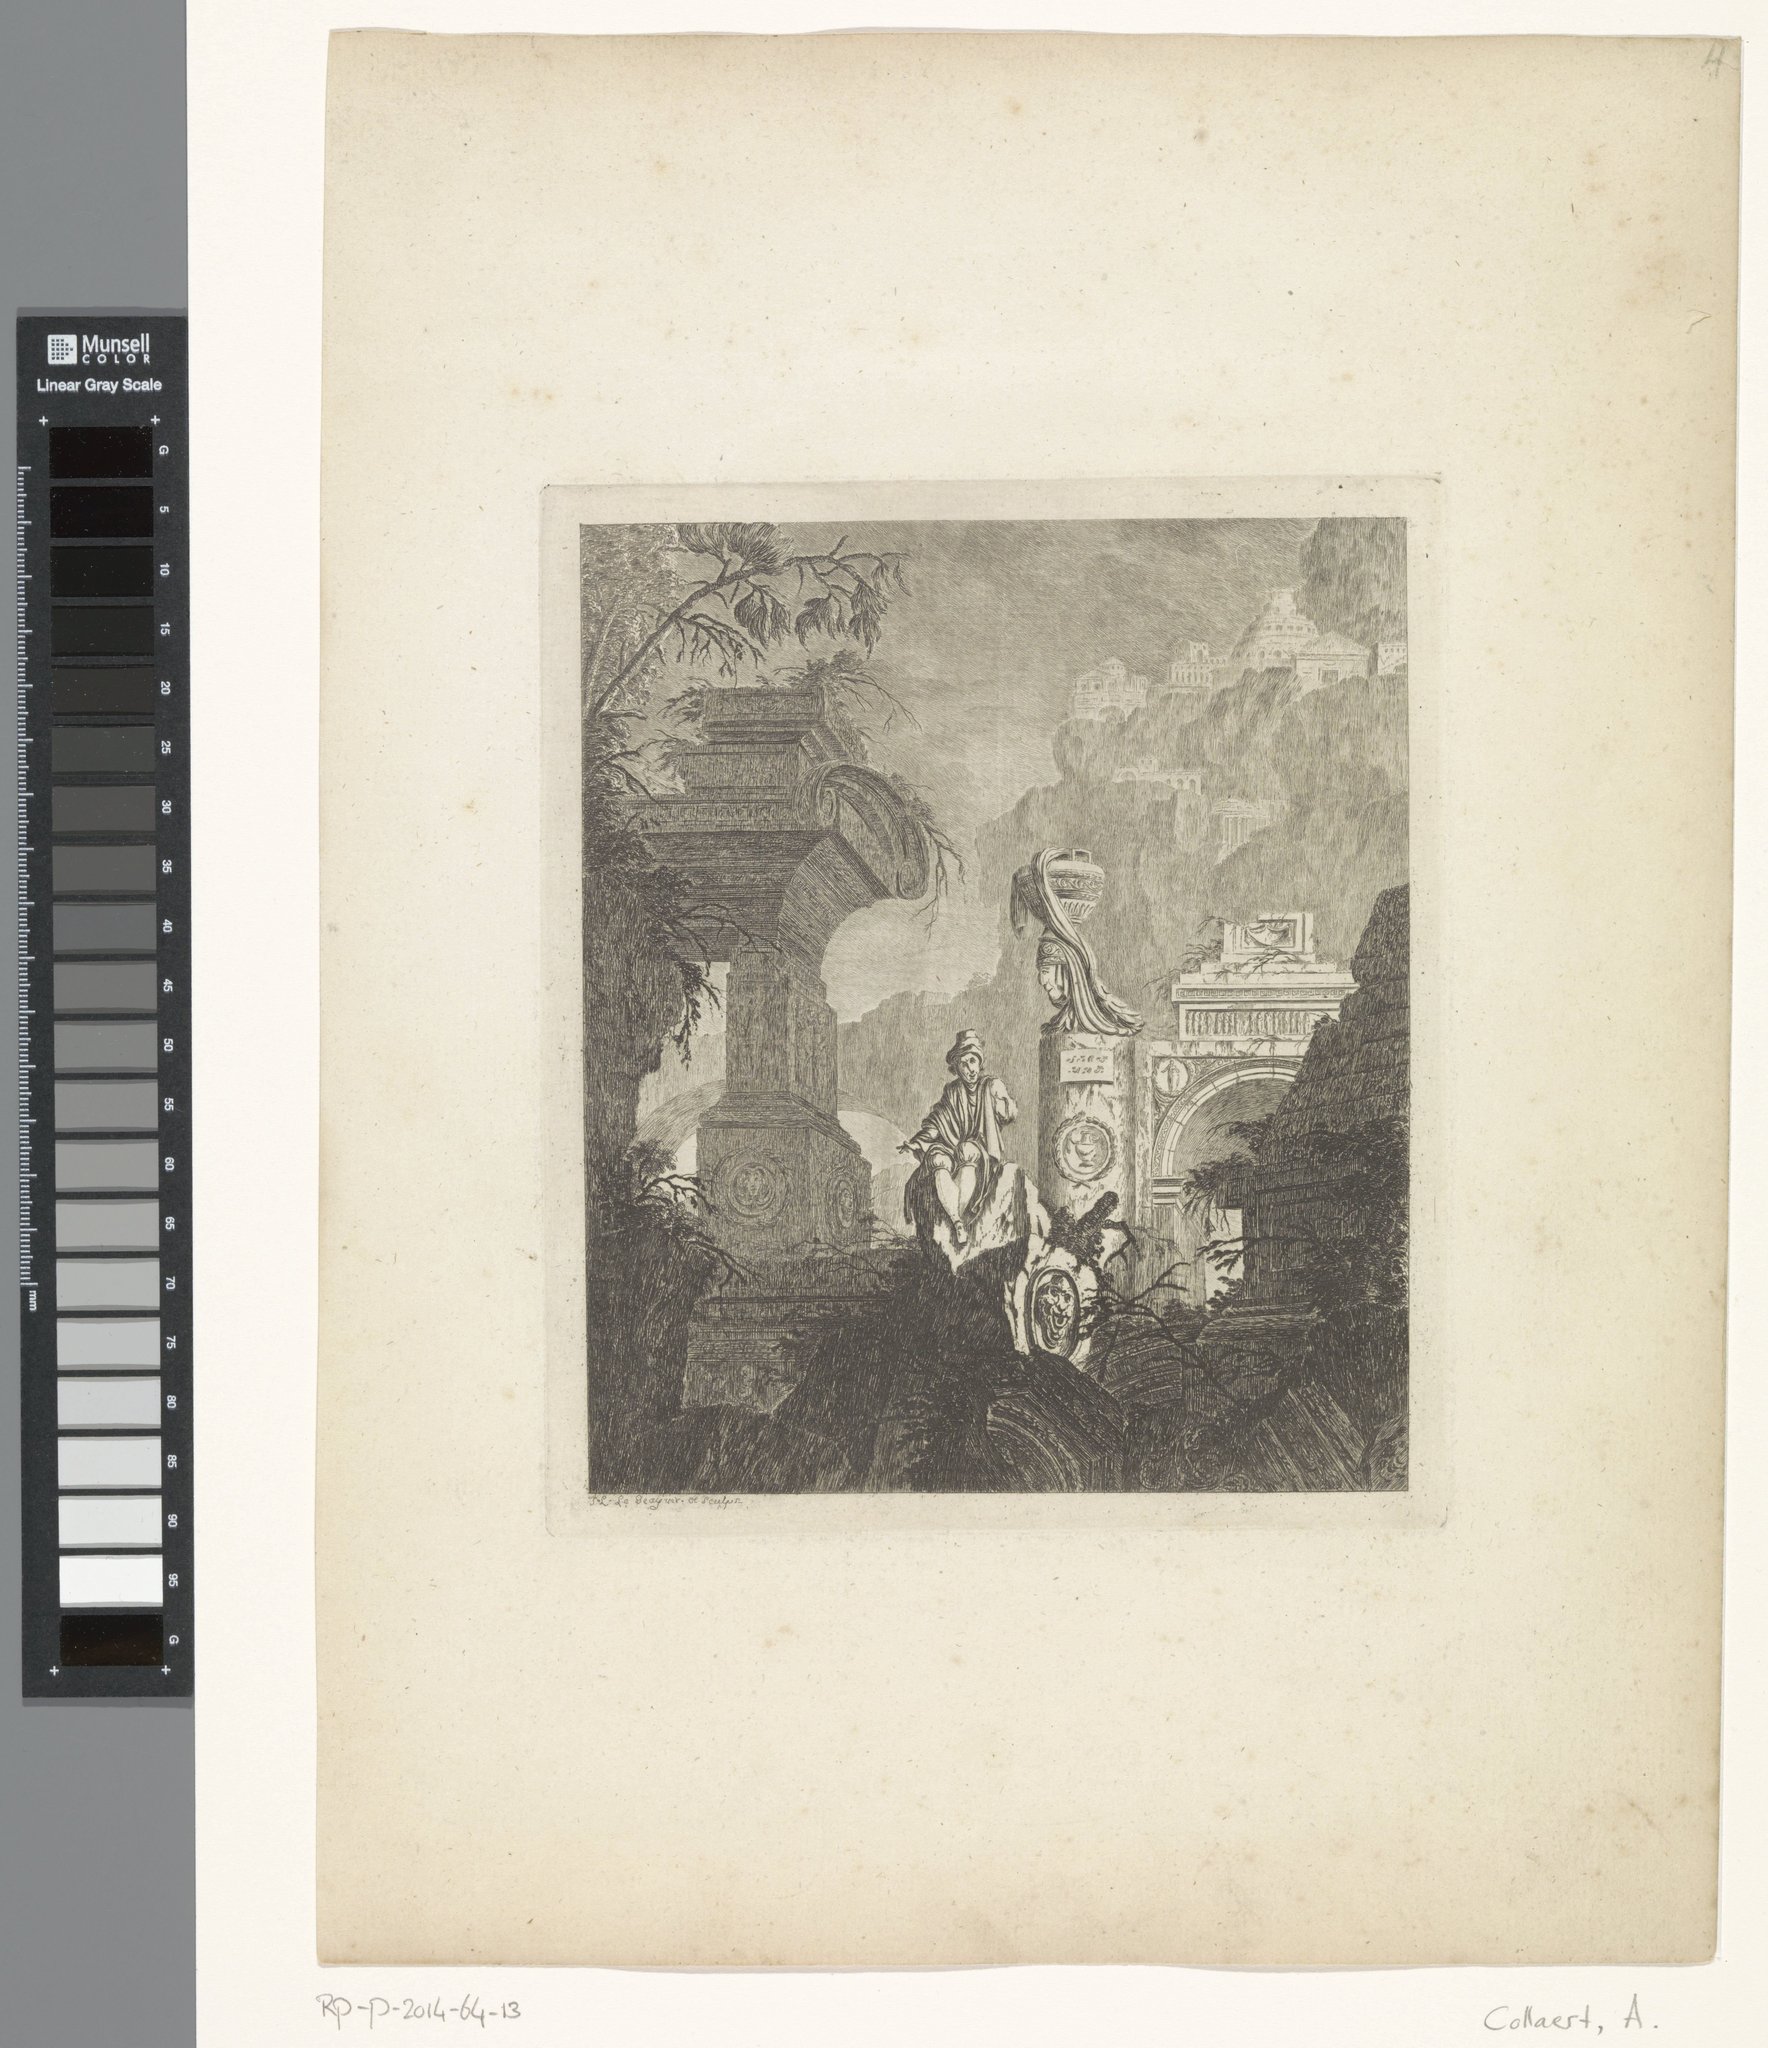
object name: ornament print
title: Landschap met ruïnes en andere antieke overblijfselen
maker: jean laurent legeay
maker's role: print maker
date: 1767-1770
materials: paper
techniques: etching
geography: france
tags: vase ~ ornament, landscape with ruins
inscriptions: collector's mark: Lugt 2228, collector's mark: Lugt 2760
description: Landschap met ruïnes en andere antieke overblijfselen. Centraal een zittende man. In een latere staat genummerd: 16. Onderdeel van groep prenten afkomstig uit één van de vier series van vazen, ruïnes, tombes en fonteinen met in totaal ca. 25 bladen.